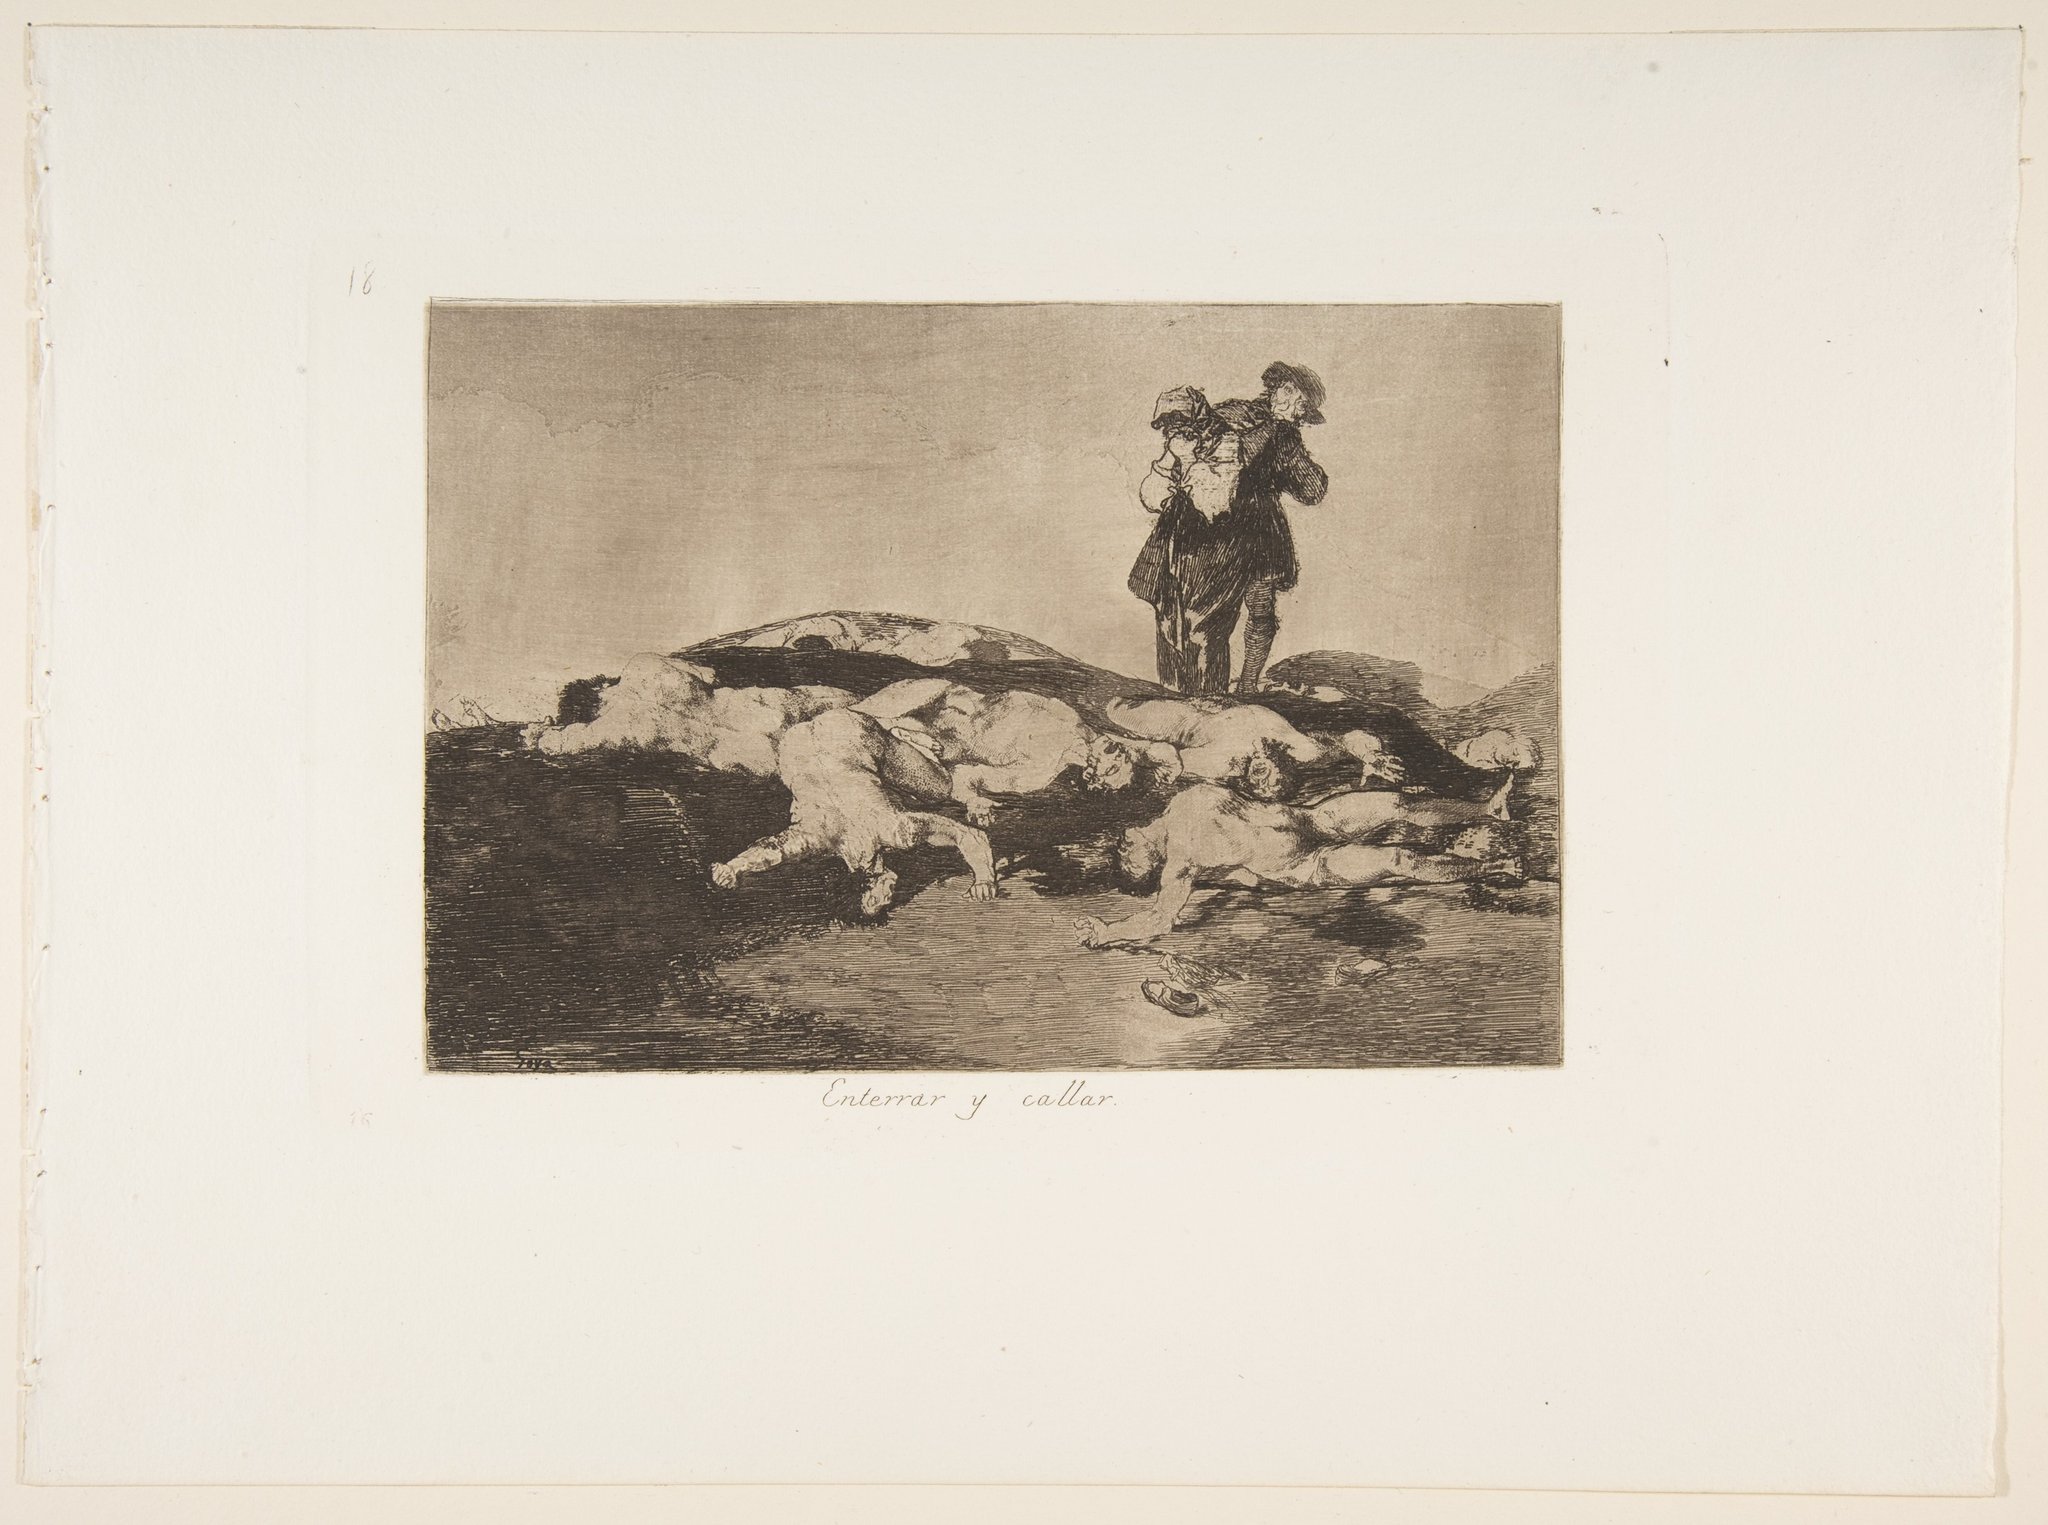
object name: print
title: Plate 18 from "The Disasters of War" (Los Desastres de la Guerra): 'Bury them and keep quiet' (Enterrar y callar)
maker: goya (francisco de goya y lucientes)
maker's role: artist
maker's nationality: spanish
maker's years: 1746-1828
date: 1810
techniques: engraving, burnishing, drypoint, etching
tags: men,death